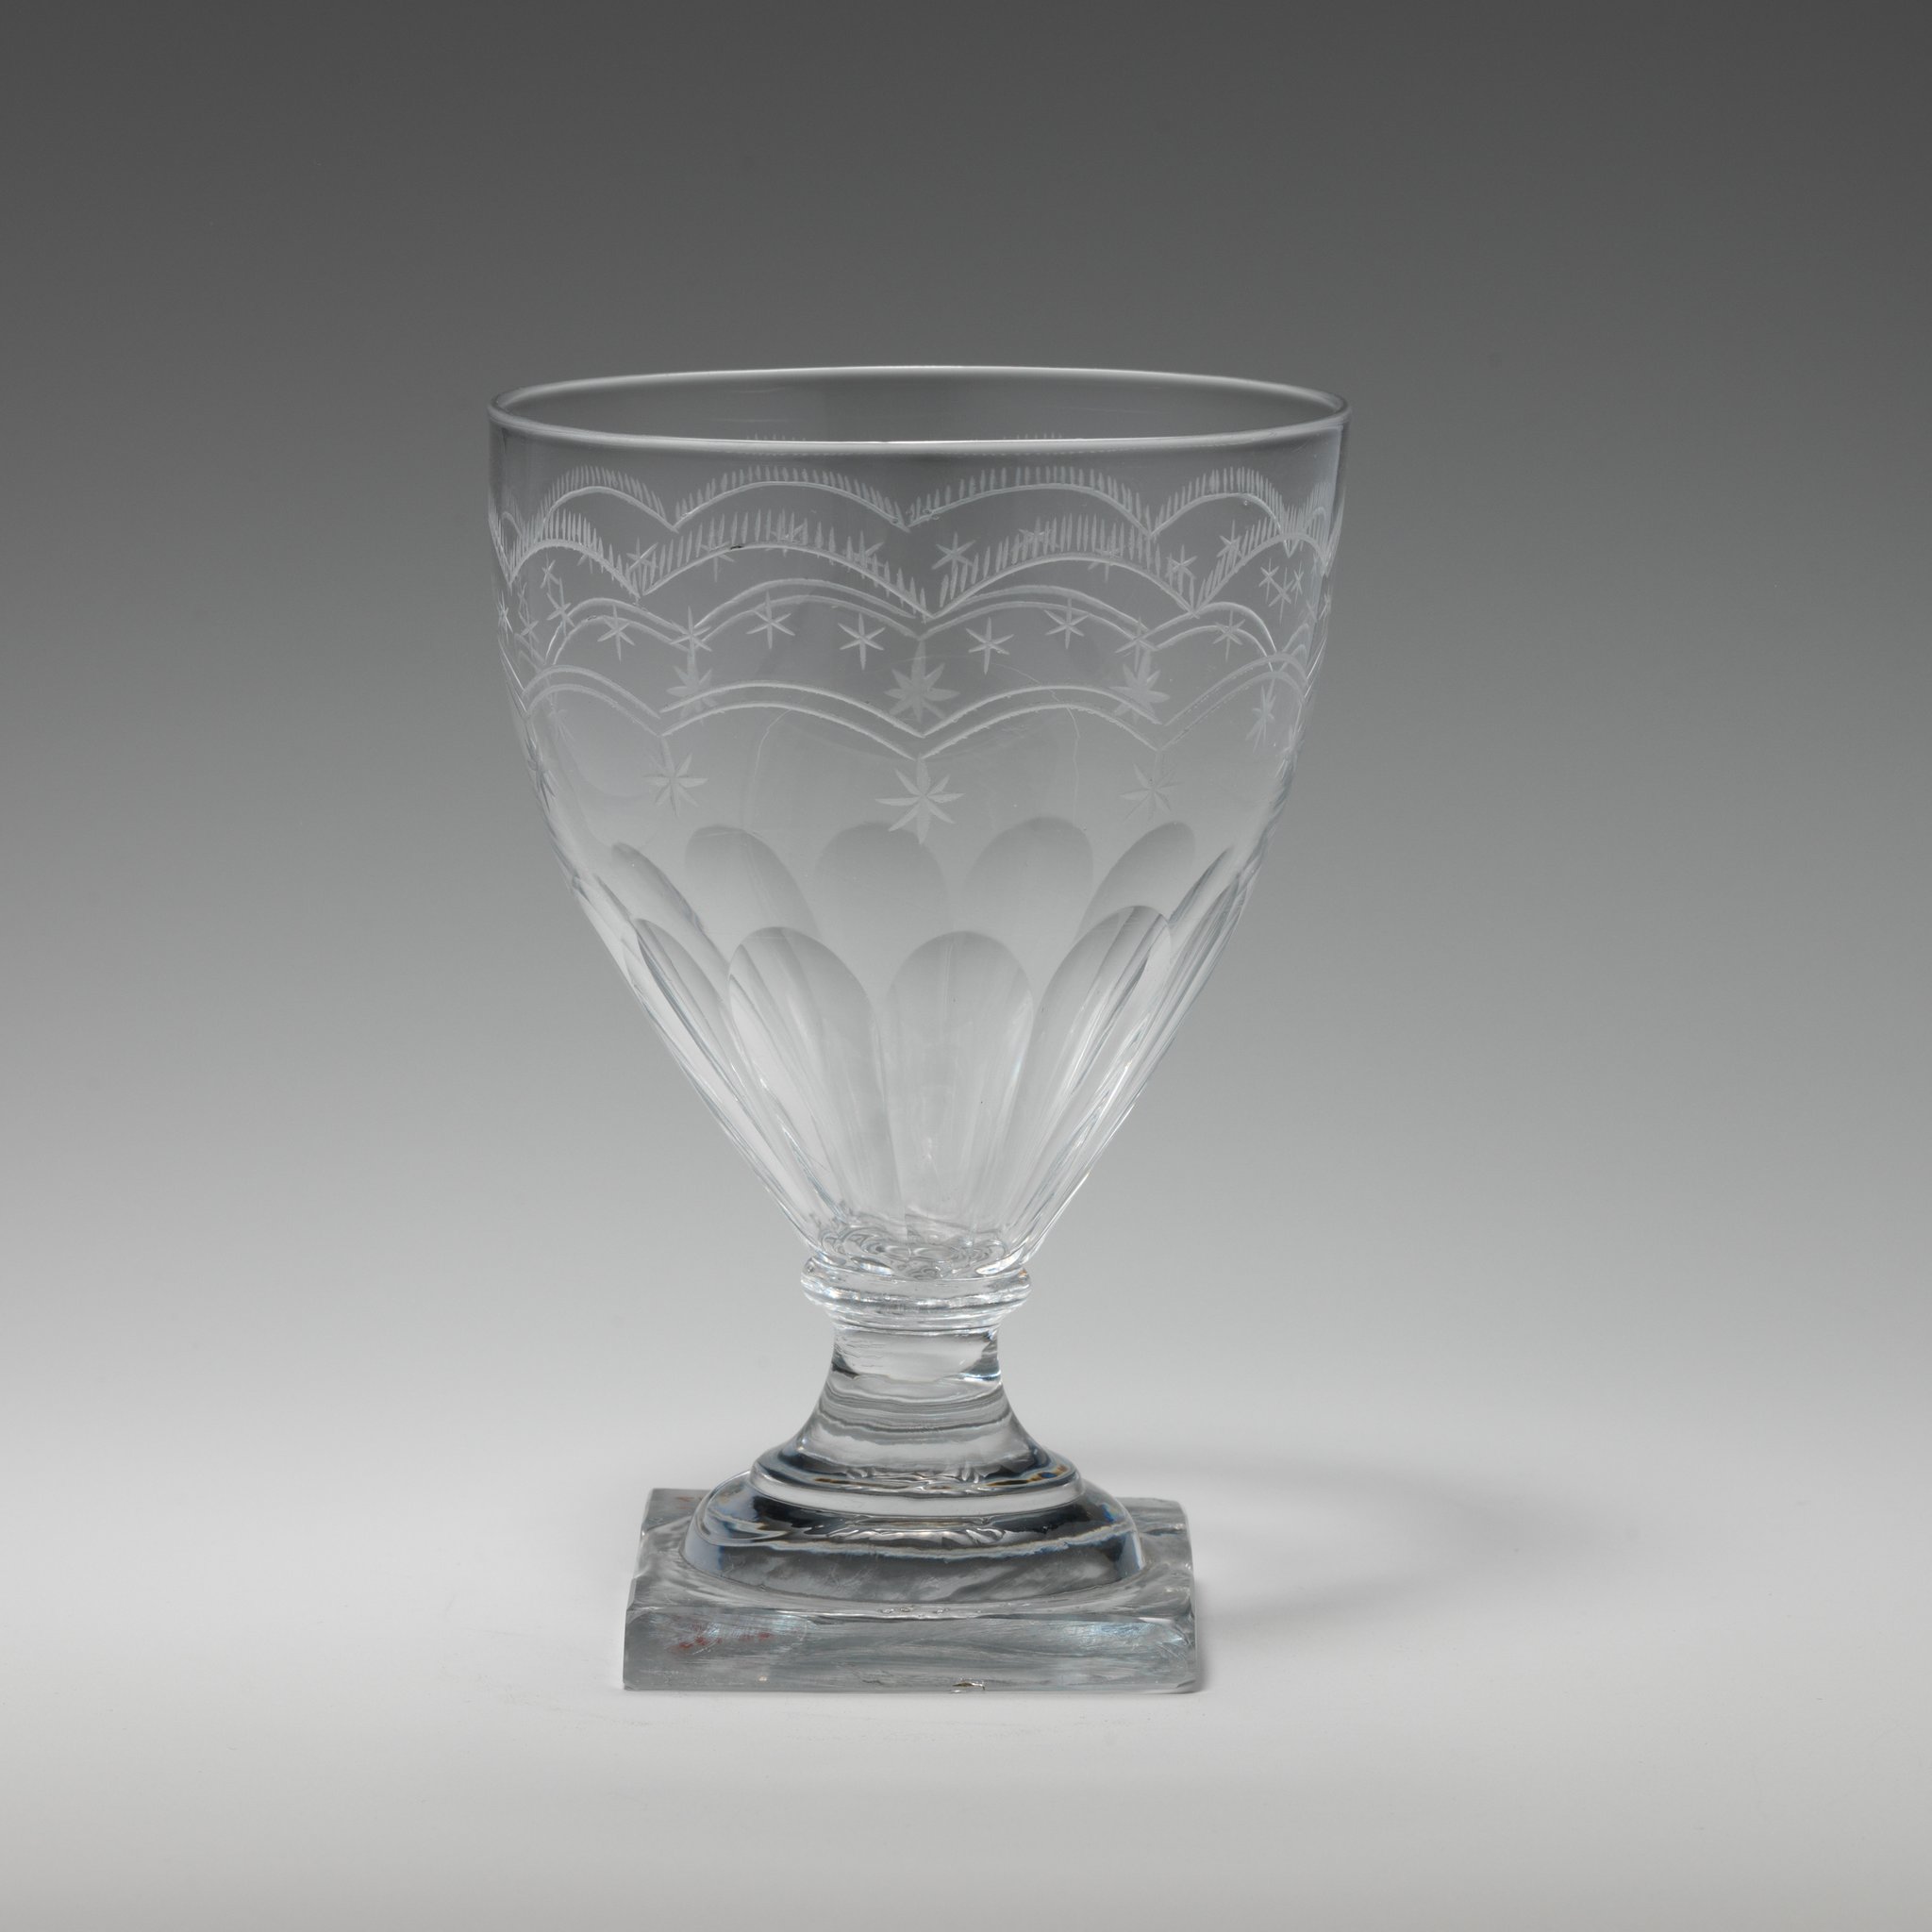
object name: goblet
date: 1790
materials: glass